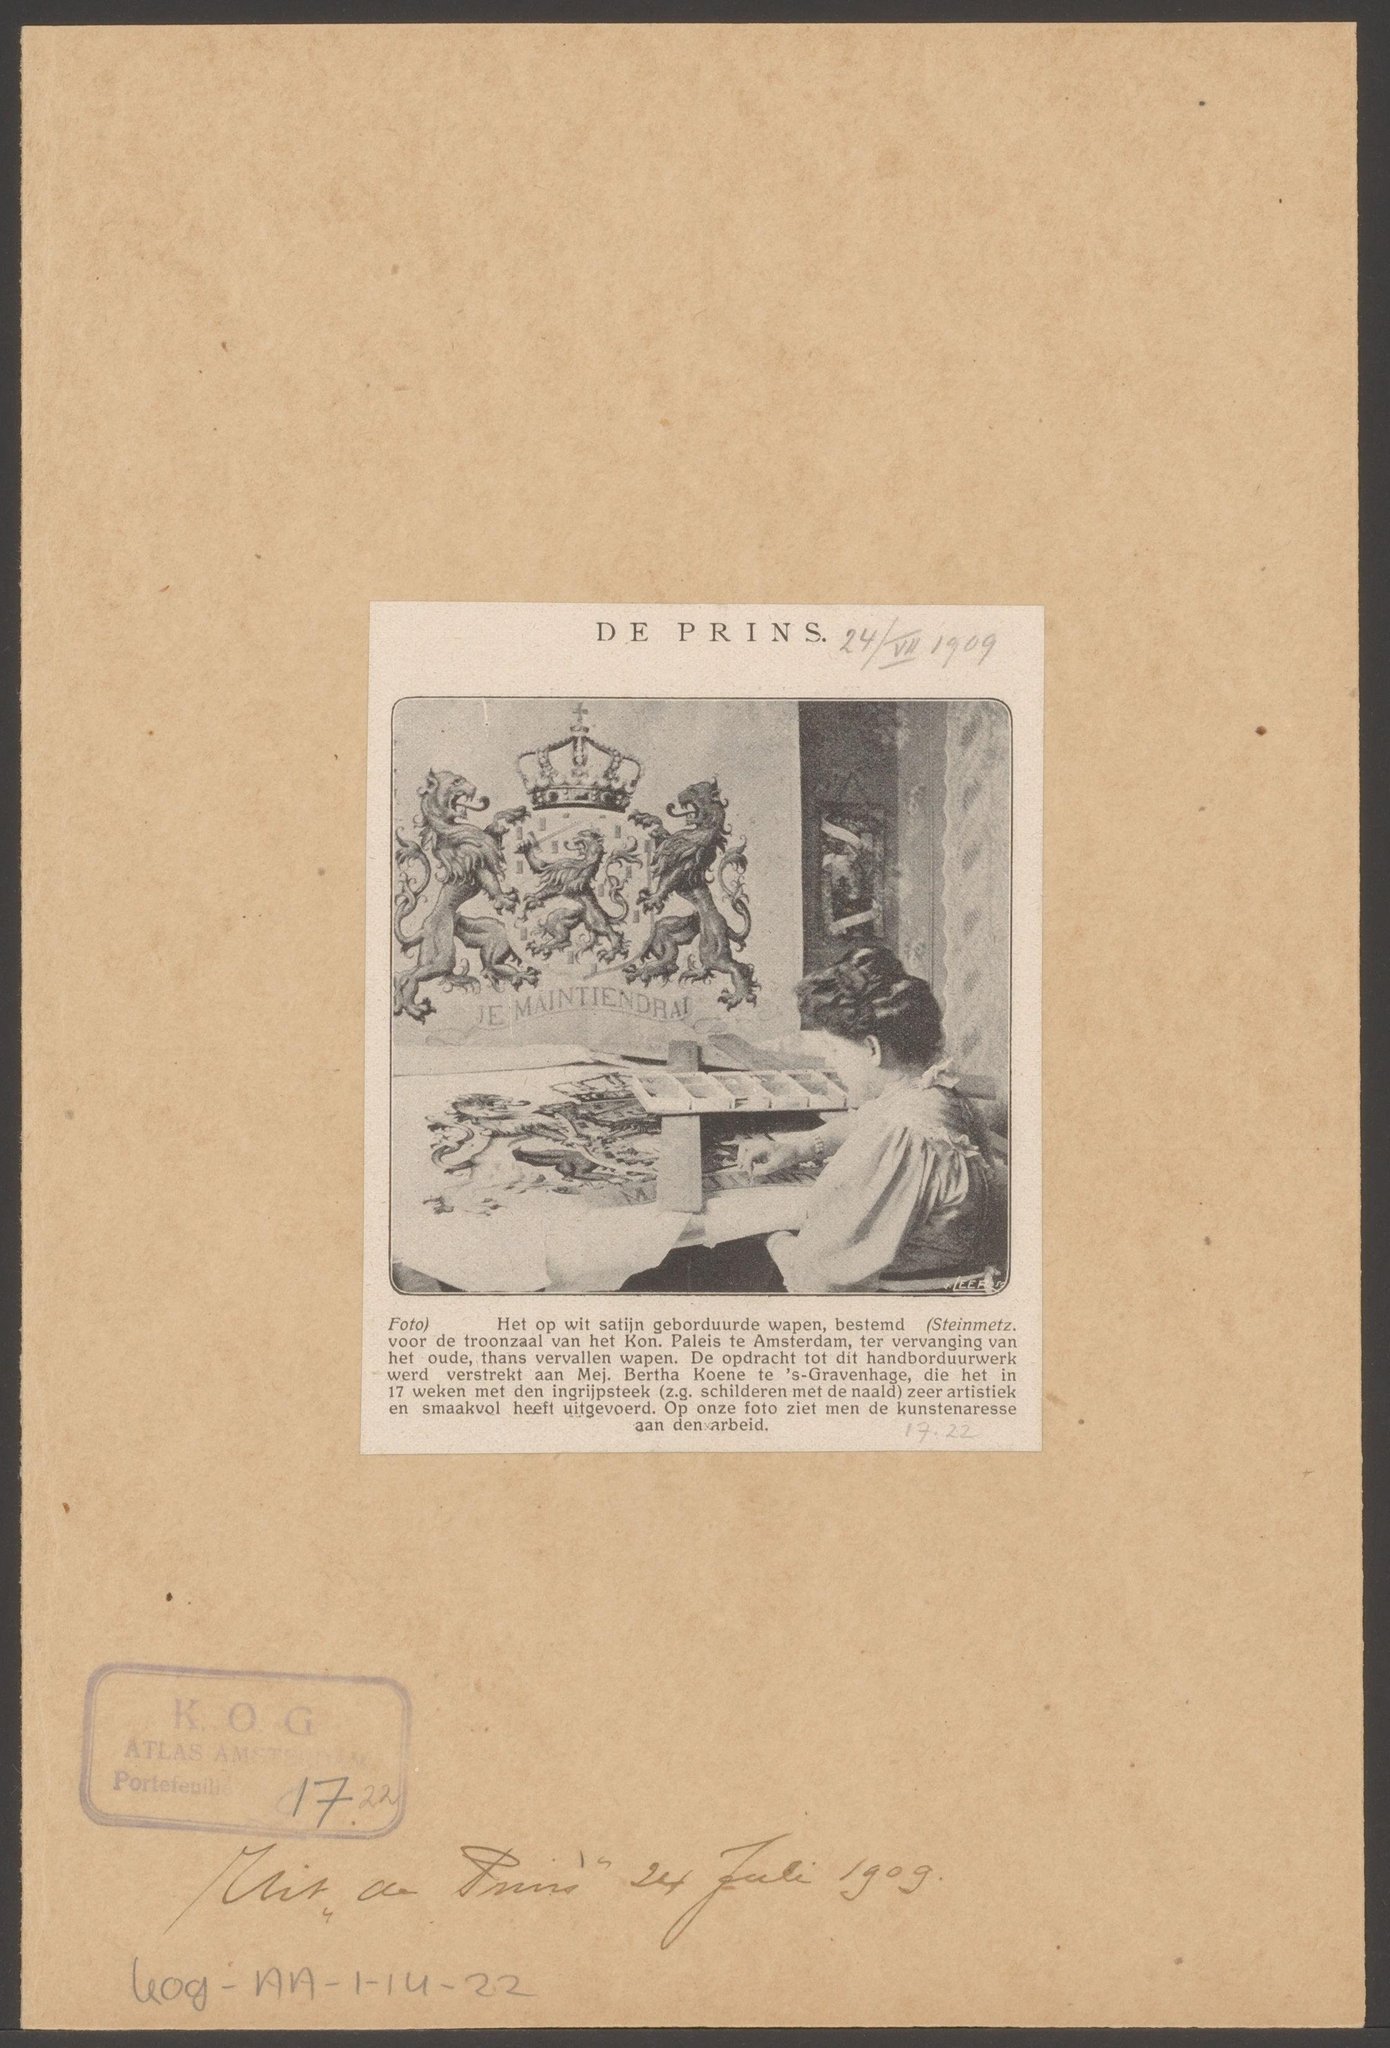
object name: photomechanical print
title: Gezicht op Bertha Koene werkend aan het geborduurde wapen van Amsterdam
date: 1909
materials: paper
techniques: letterpress printing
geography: amsterdam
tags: embroidering ~ textile industry, townhall, armorial bearing, heraldry, royal palace of amsterdam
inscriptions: collector's mark: ‘17.22’ Lugt 1641b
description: Onderwerpsrubriek binnen de Atlas Amsterdam: Nieuwe Stadhuis, van binnen: Groote zaal, Raadkamer, Schepenkamer, Troonzaal, Mozeszaal, Zitkamer.